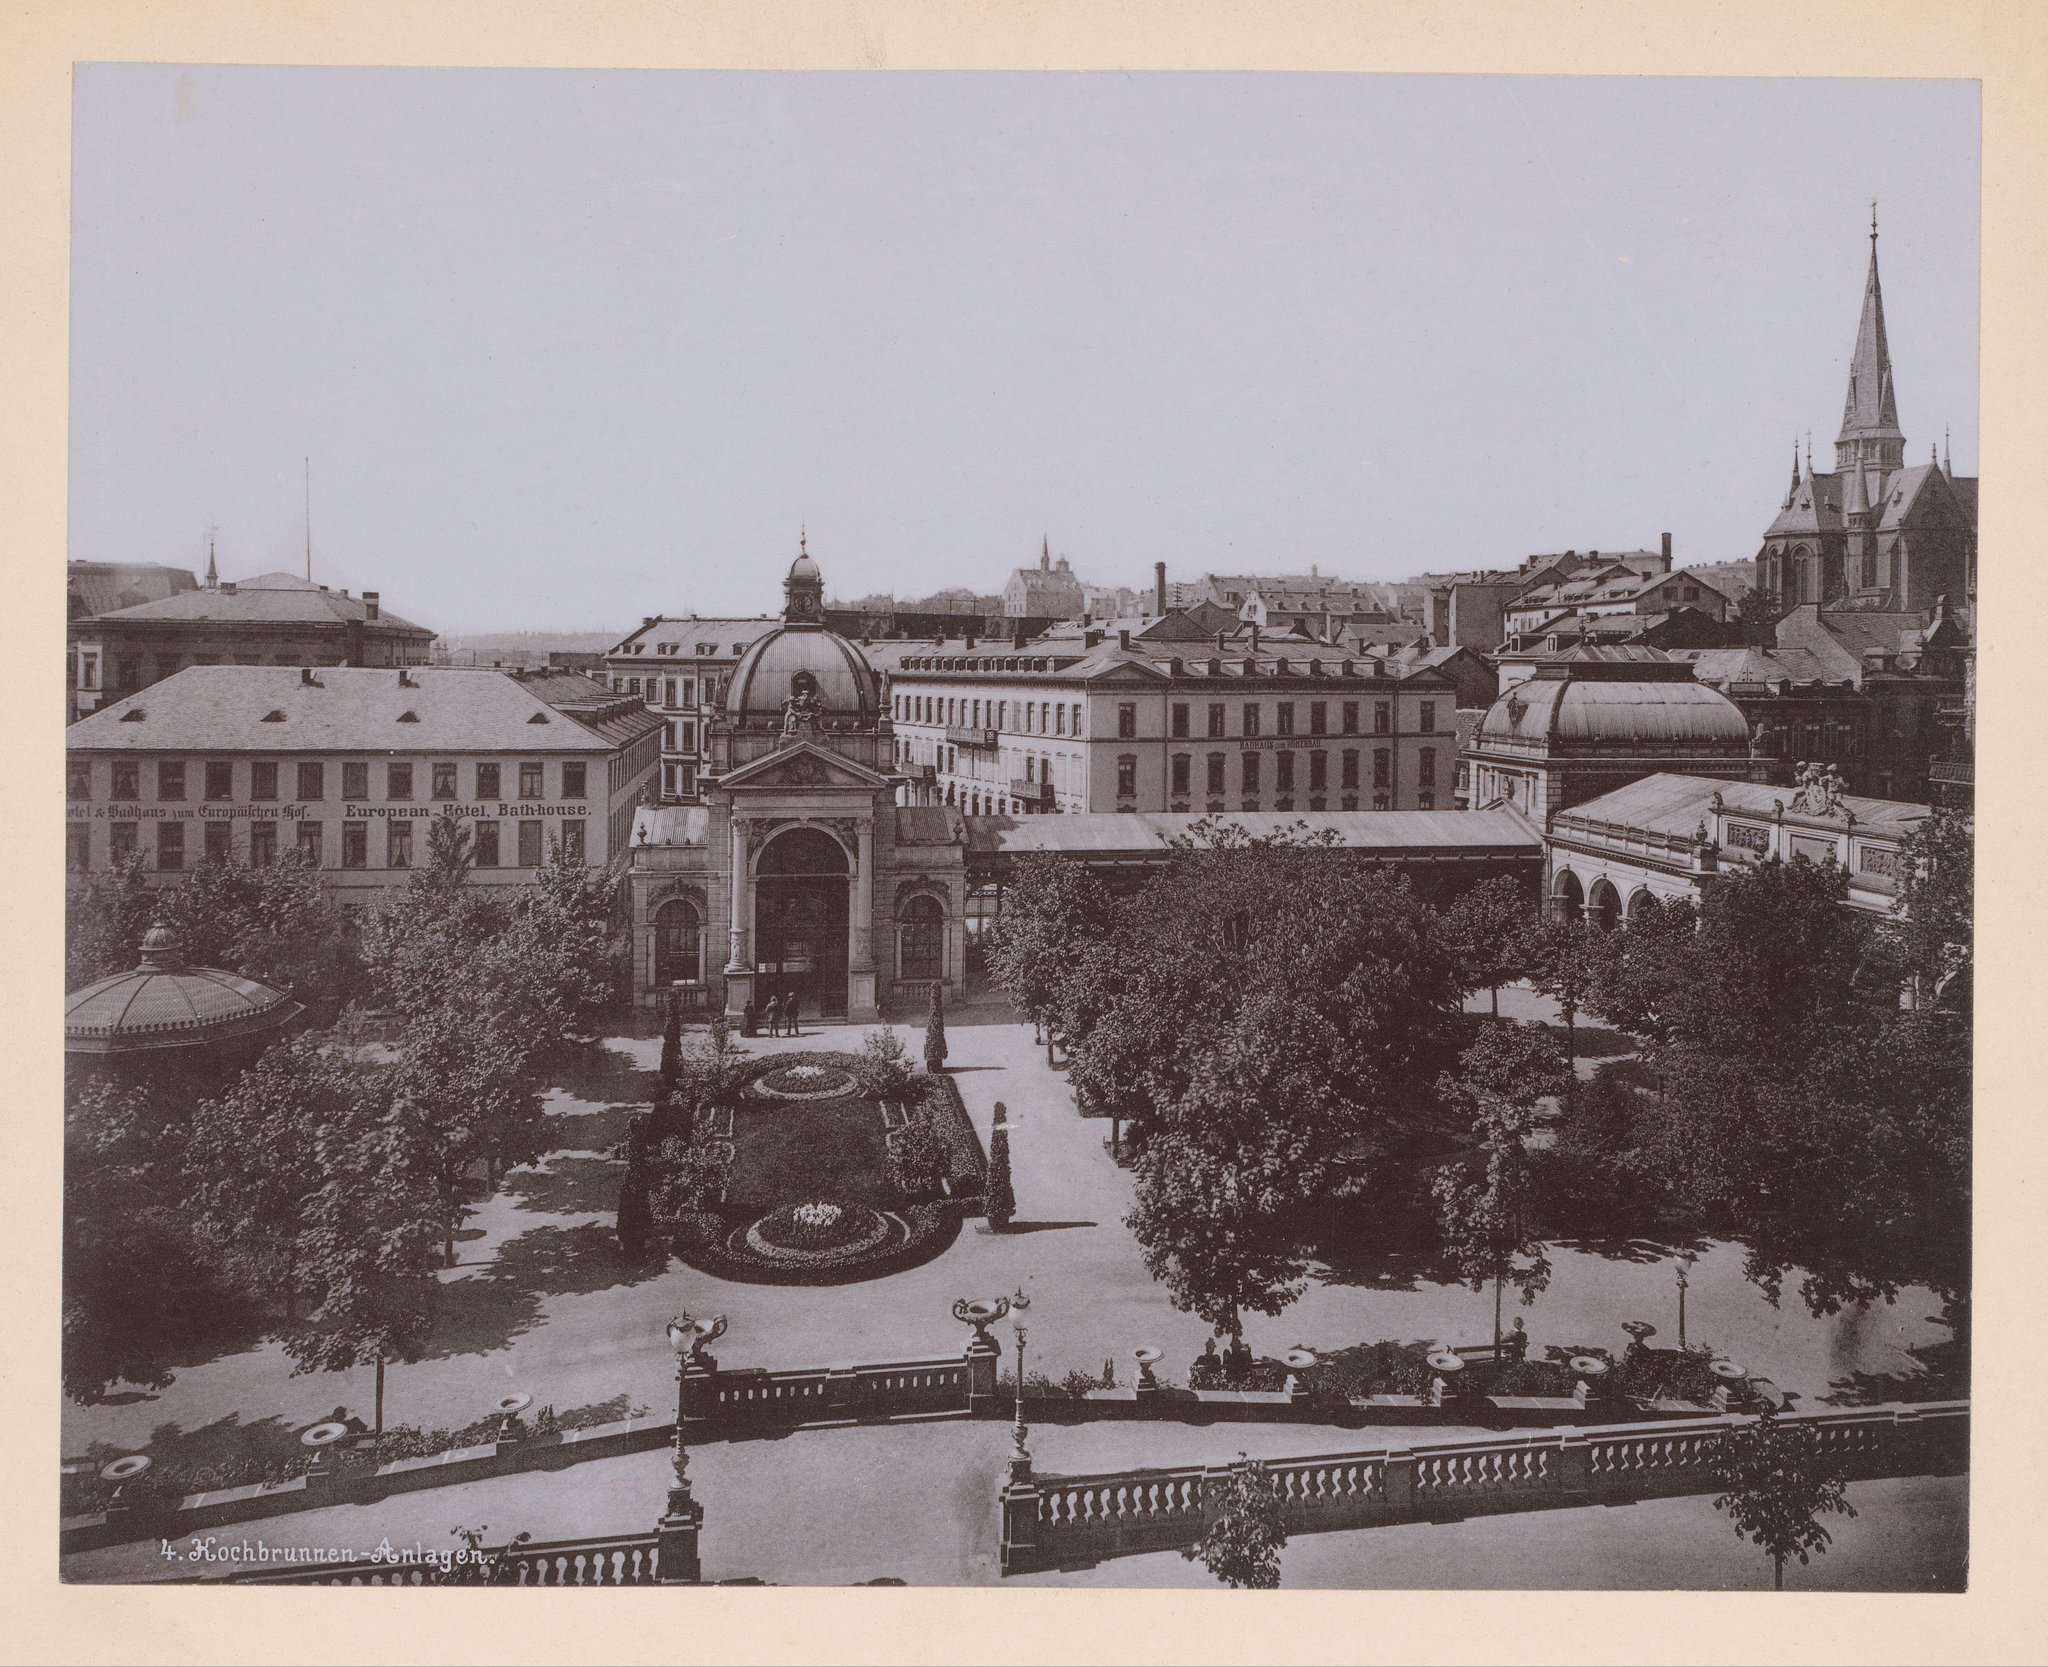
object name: photograph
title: Kochbrunnen, Wiesbaden, Duitsland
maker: Anonymous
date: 1890-1900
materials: cardboard, paper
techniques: photograph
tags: wiesbaden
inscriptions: inscription: ‘4. Kochbrunnen-Anlagen.’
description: Gezicht van boven op een park en een classicistisch gebouw op de achtergrond, rechts een kerk.